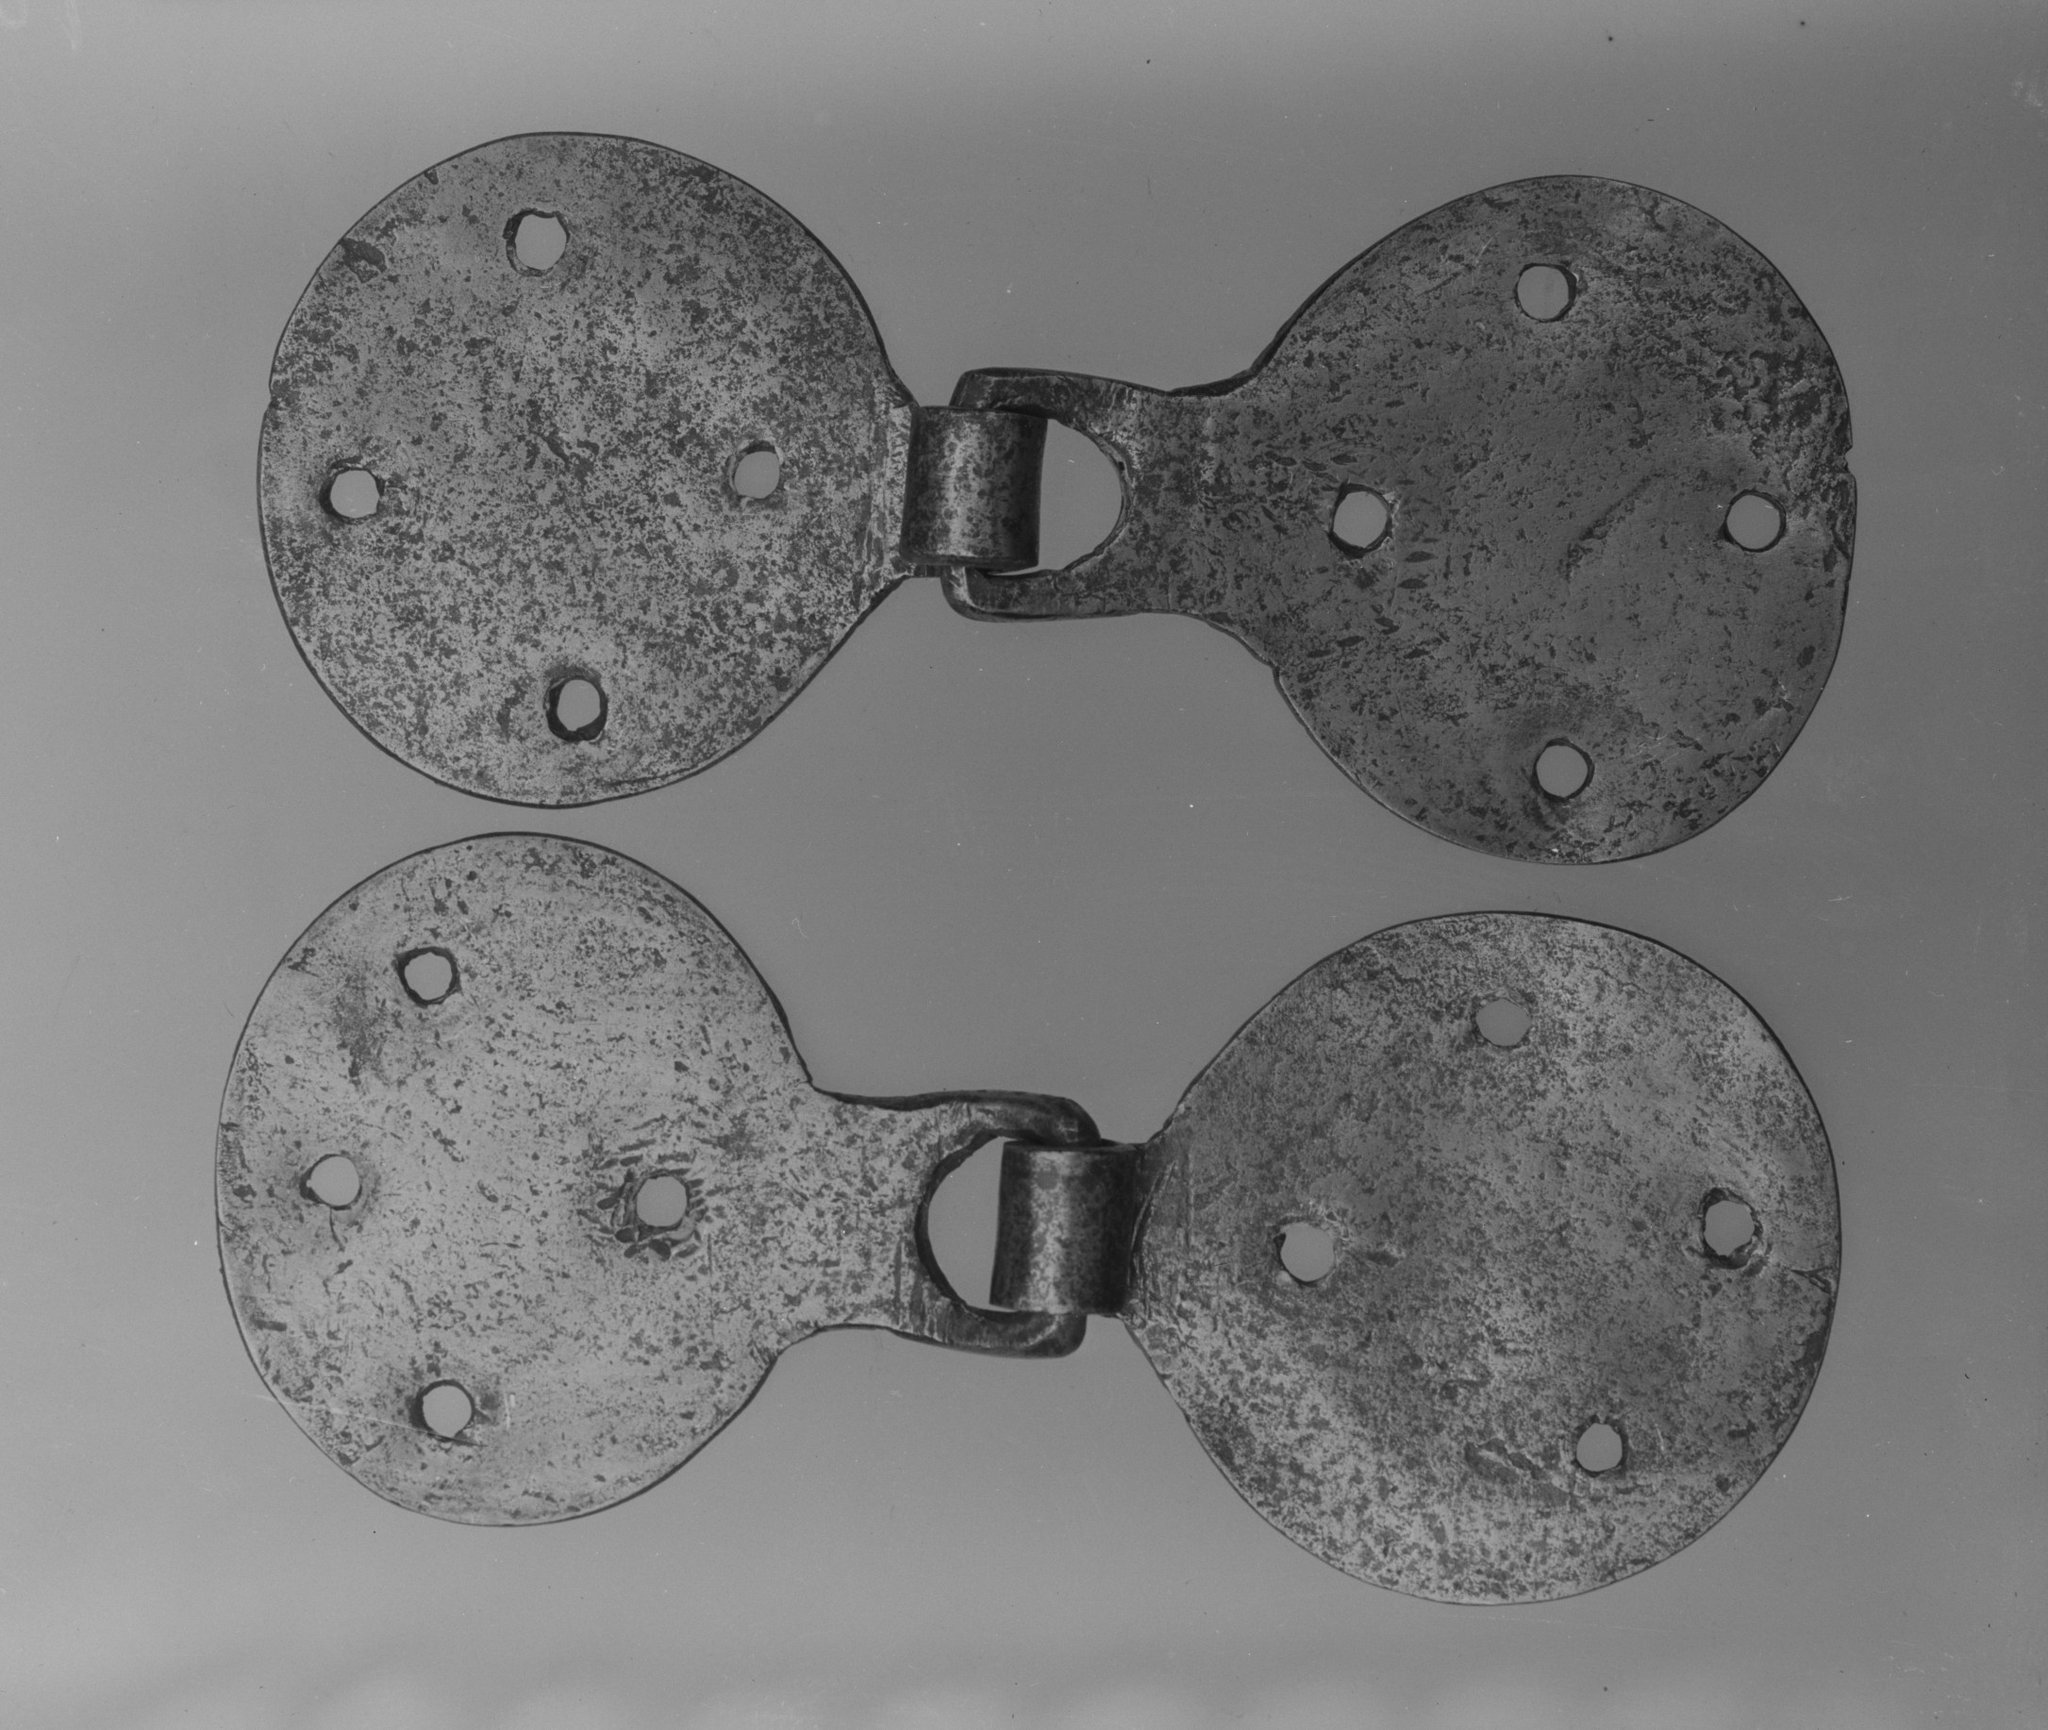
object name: hinge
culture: american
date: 1700-1730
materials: iron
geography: united states